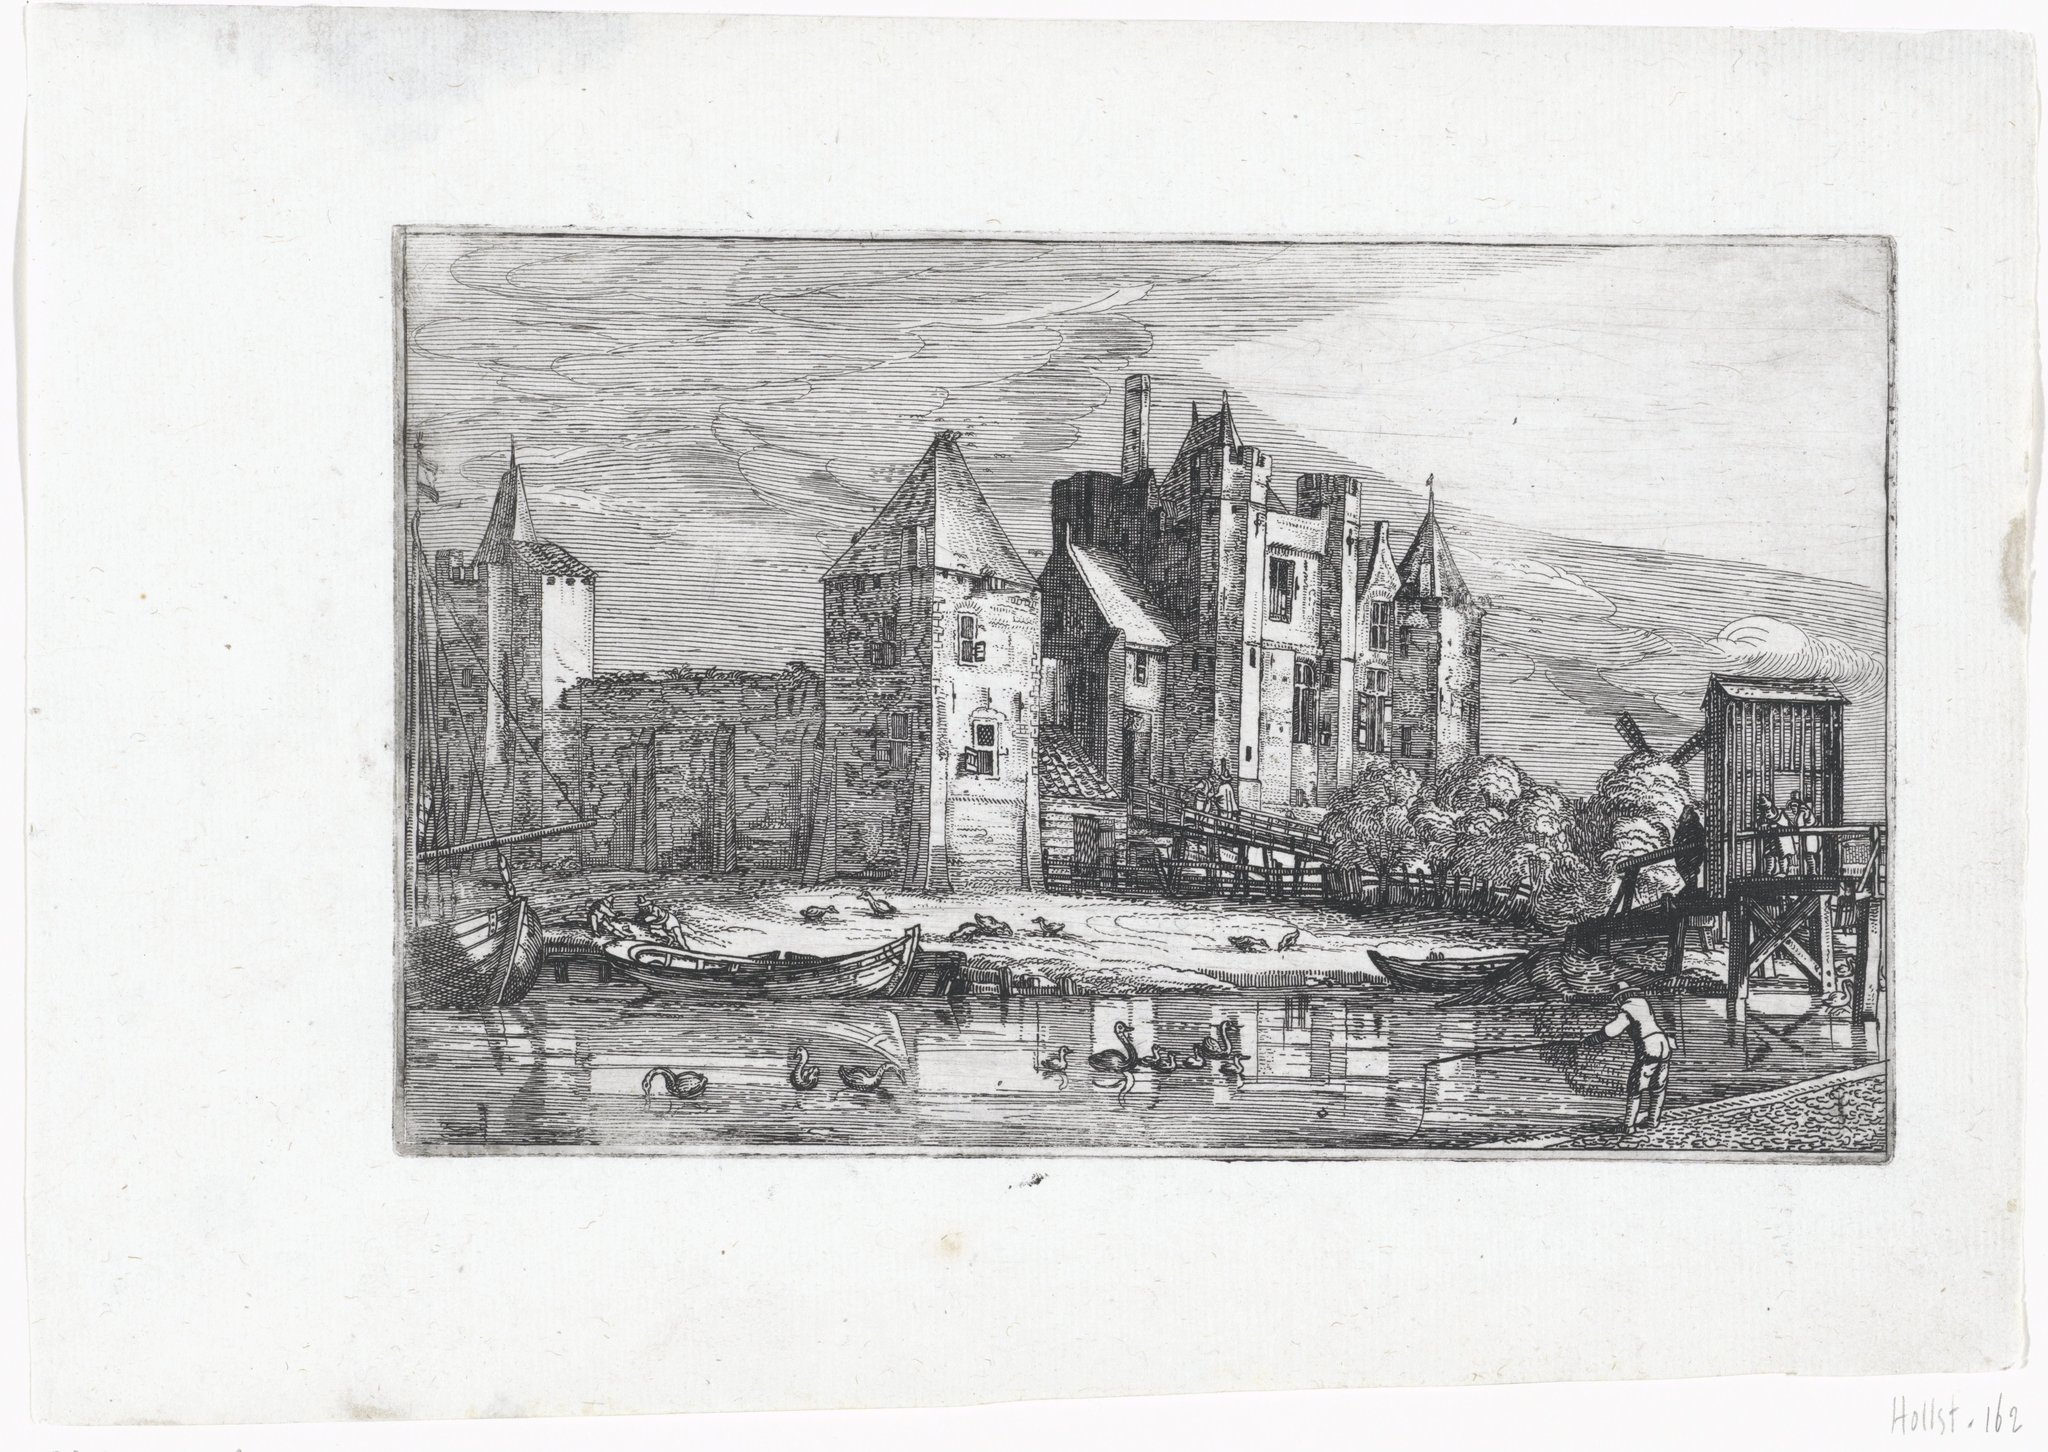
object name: print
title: Slot Purmersteijn te Purmerend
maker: claes jansz. visscher (ii)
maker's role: draughtsman, print maker, publisher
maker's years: 1586-1652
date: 1596-1630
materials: paper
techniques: etching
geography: amsterdam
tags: moat ~ fortified city, castle, fisherman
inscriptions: collector's mark: Lugt 2228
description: Hollstein noemt voor deze reeks verder alleen de afdrukken in Wenen. Deze reeks zou voorafgaan aan de tweede versie (Hollstein 165-168) waarin de kastelen in de juiste richting zijn weergegeven en zijn voorzien van topografische duidingen in het onderschrift.